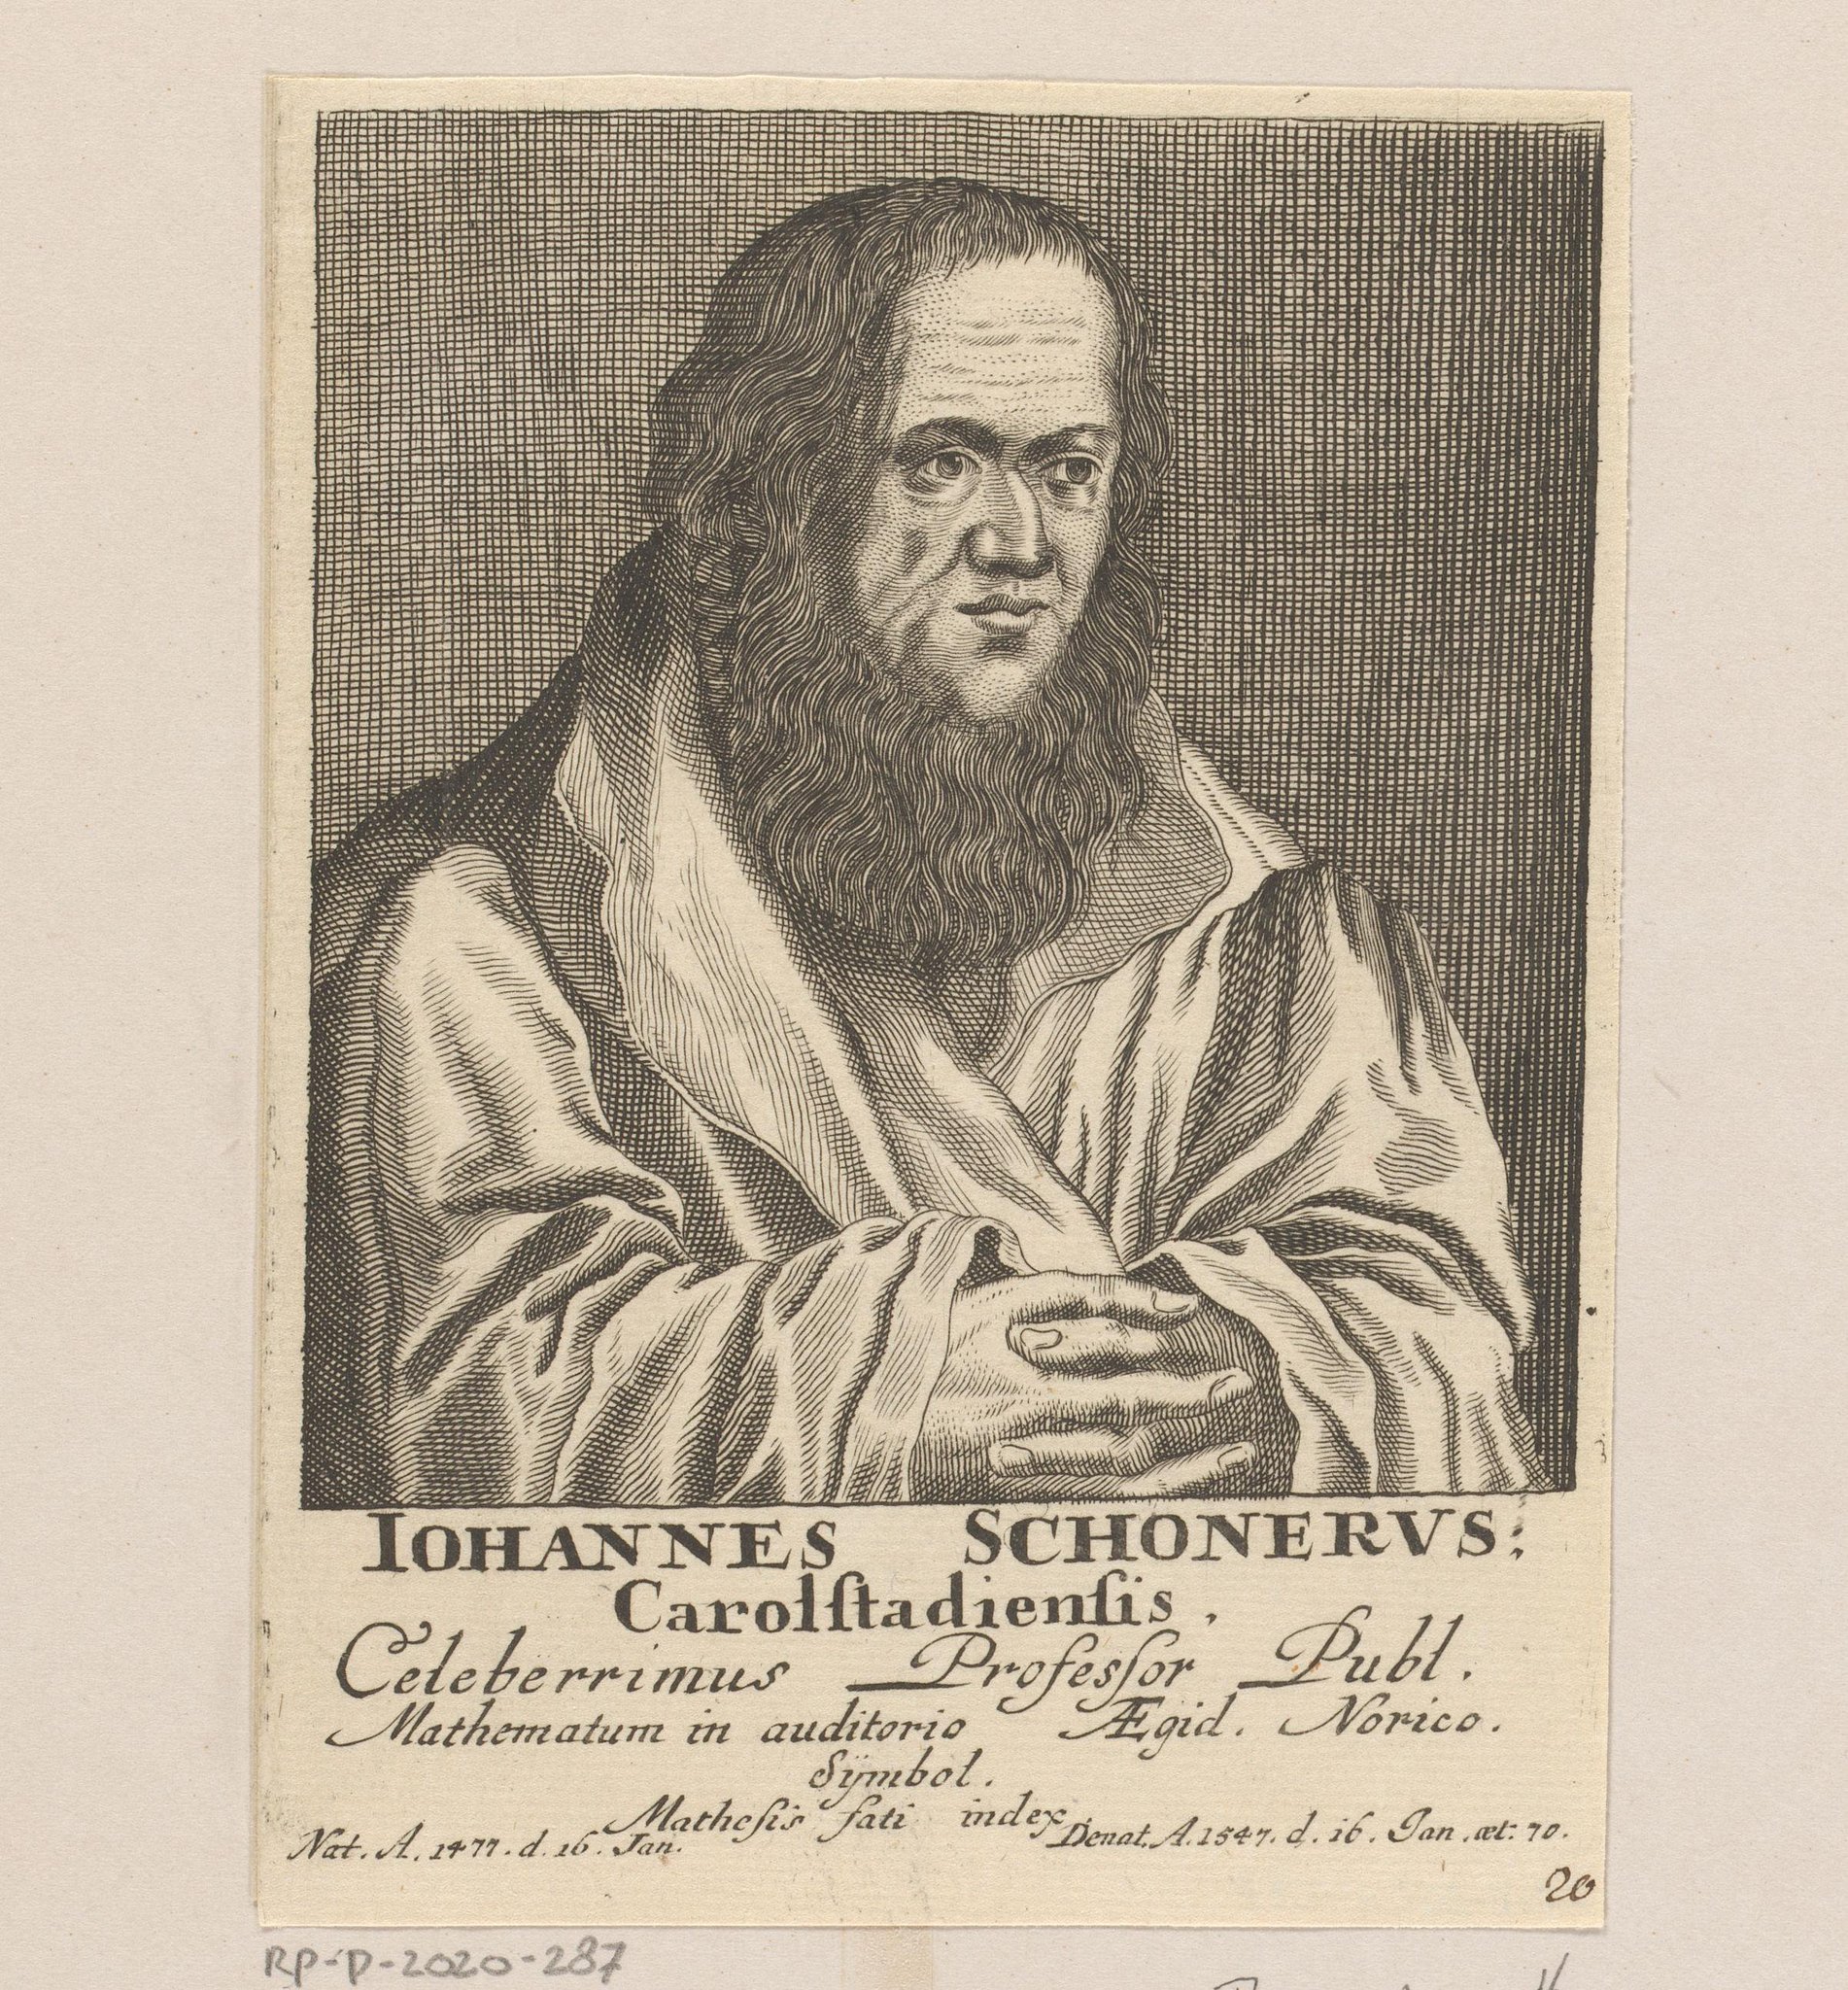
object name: book illustration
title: Portret van Johannes Schöner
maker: Anonymous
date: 1725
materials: paper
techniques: engraving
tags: historical persons, mathematics (+ portrait of scholar, scientist)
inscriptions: inscription: ‘20’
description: Prent mogelijk gebruikt in: Roth-Scholtz, Friedrich. Icones virorum omnium ordinum eruditione: omnique item genere et varietate artium de republica litteraria et speciatim de Academiis et Gymnasiis (...). Neurenberg: erven Johann Daniel Tauber, 1725, dl. 1.